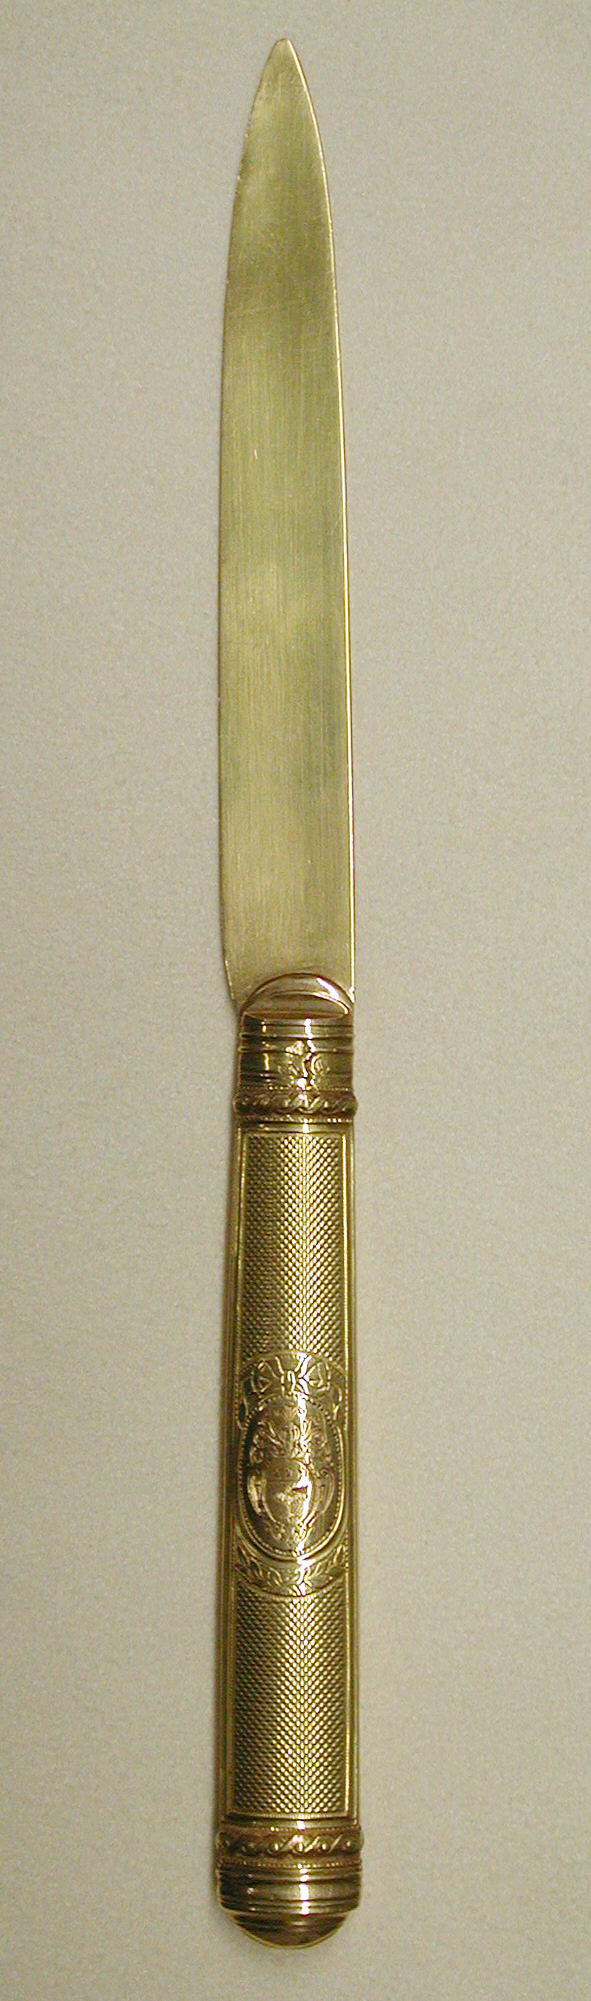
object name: knife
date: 1781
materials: gold, steel